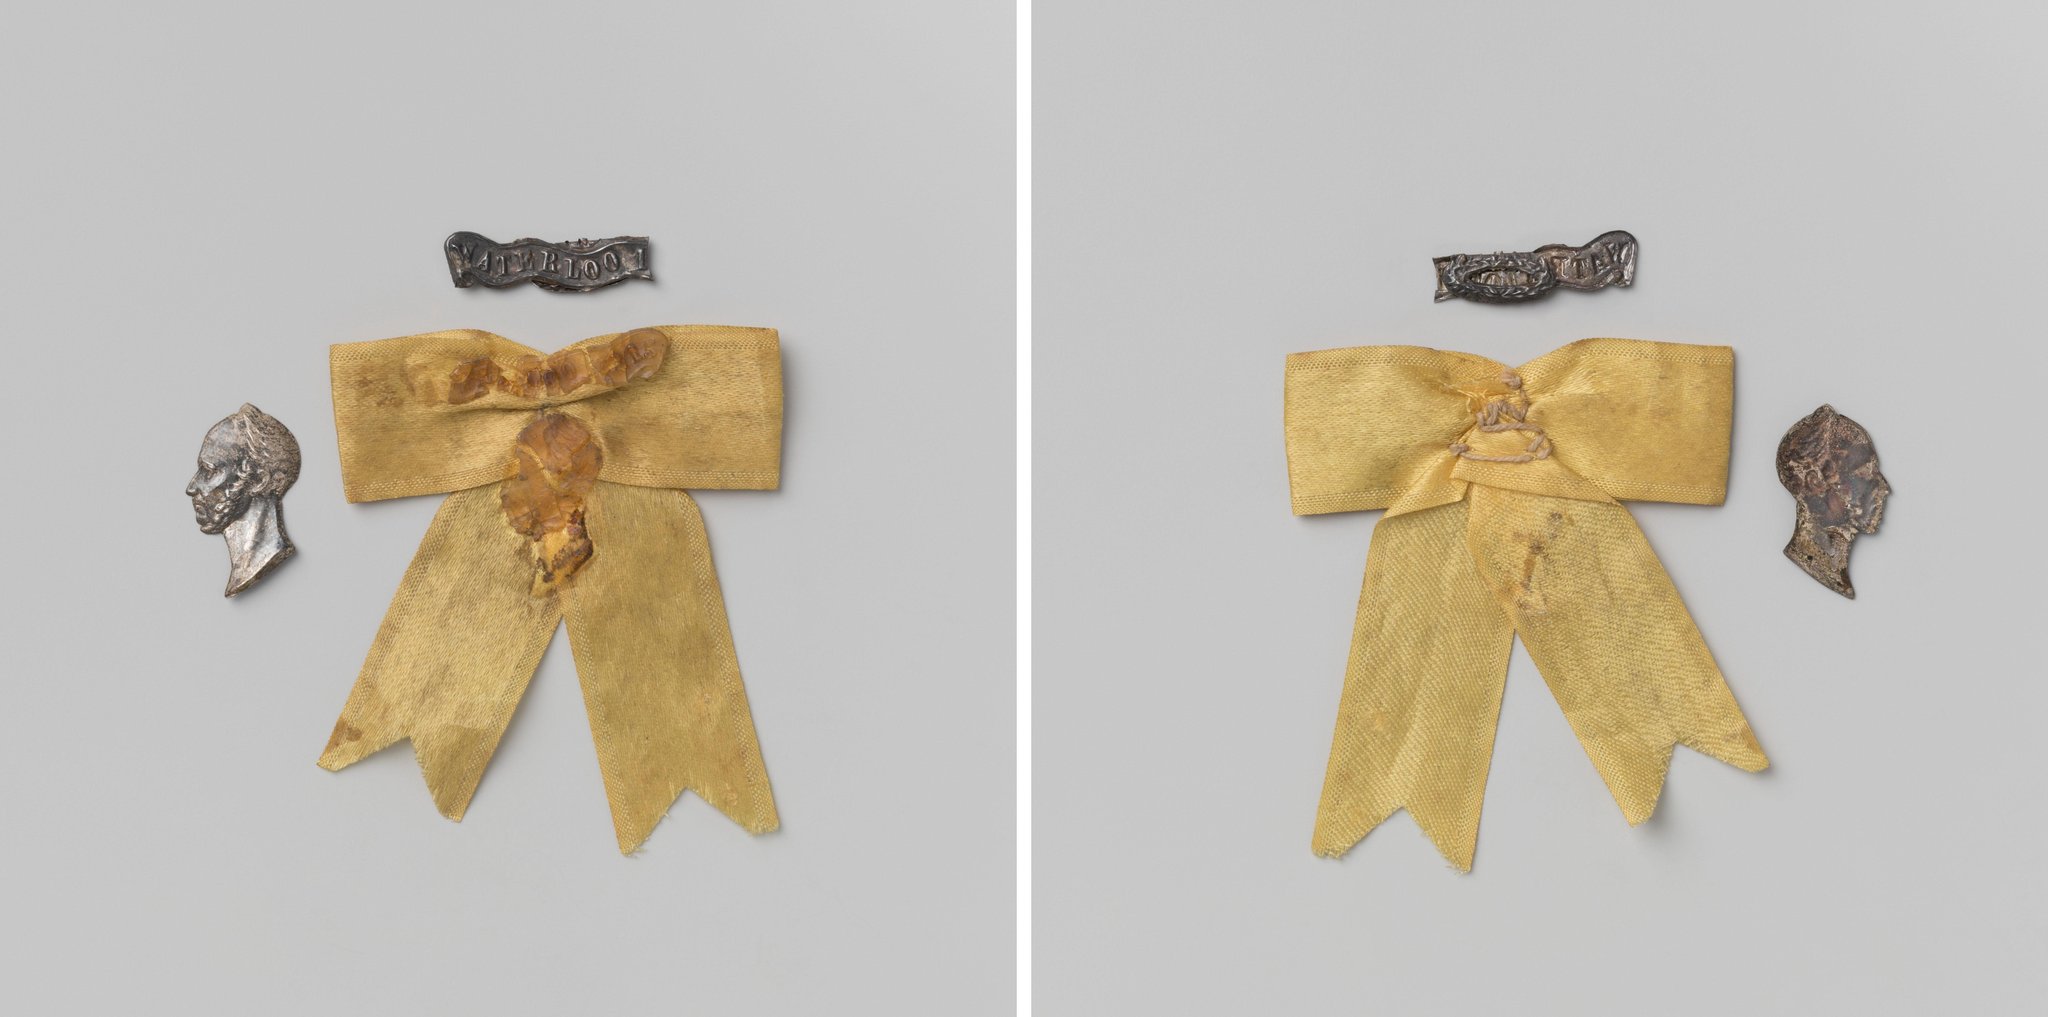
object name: insignia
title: Vijftigjarige viering van slag bij Waterloo, draagteken ter ere van Willem II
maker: Anonymous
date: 1865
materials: silver, textile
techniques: striking, weave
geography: netherlands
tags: the hague, william ii of the netherlands, waterloo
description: Eenzijdig zilveren draagteken op gele strik, bestaande uit twee losse delen: boven een lauwerkrans op wimpel met opschrift; daaronder borststuk man naar links